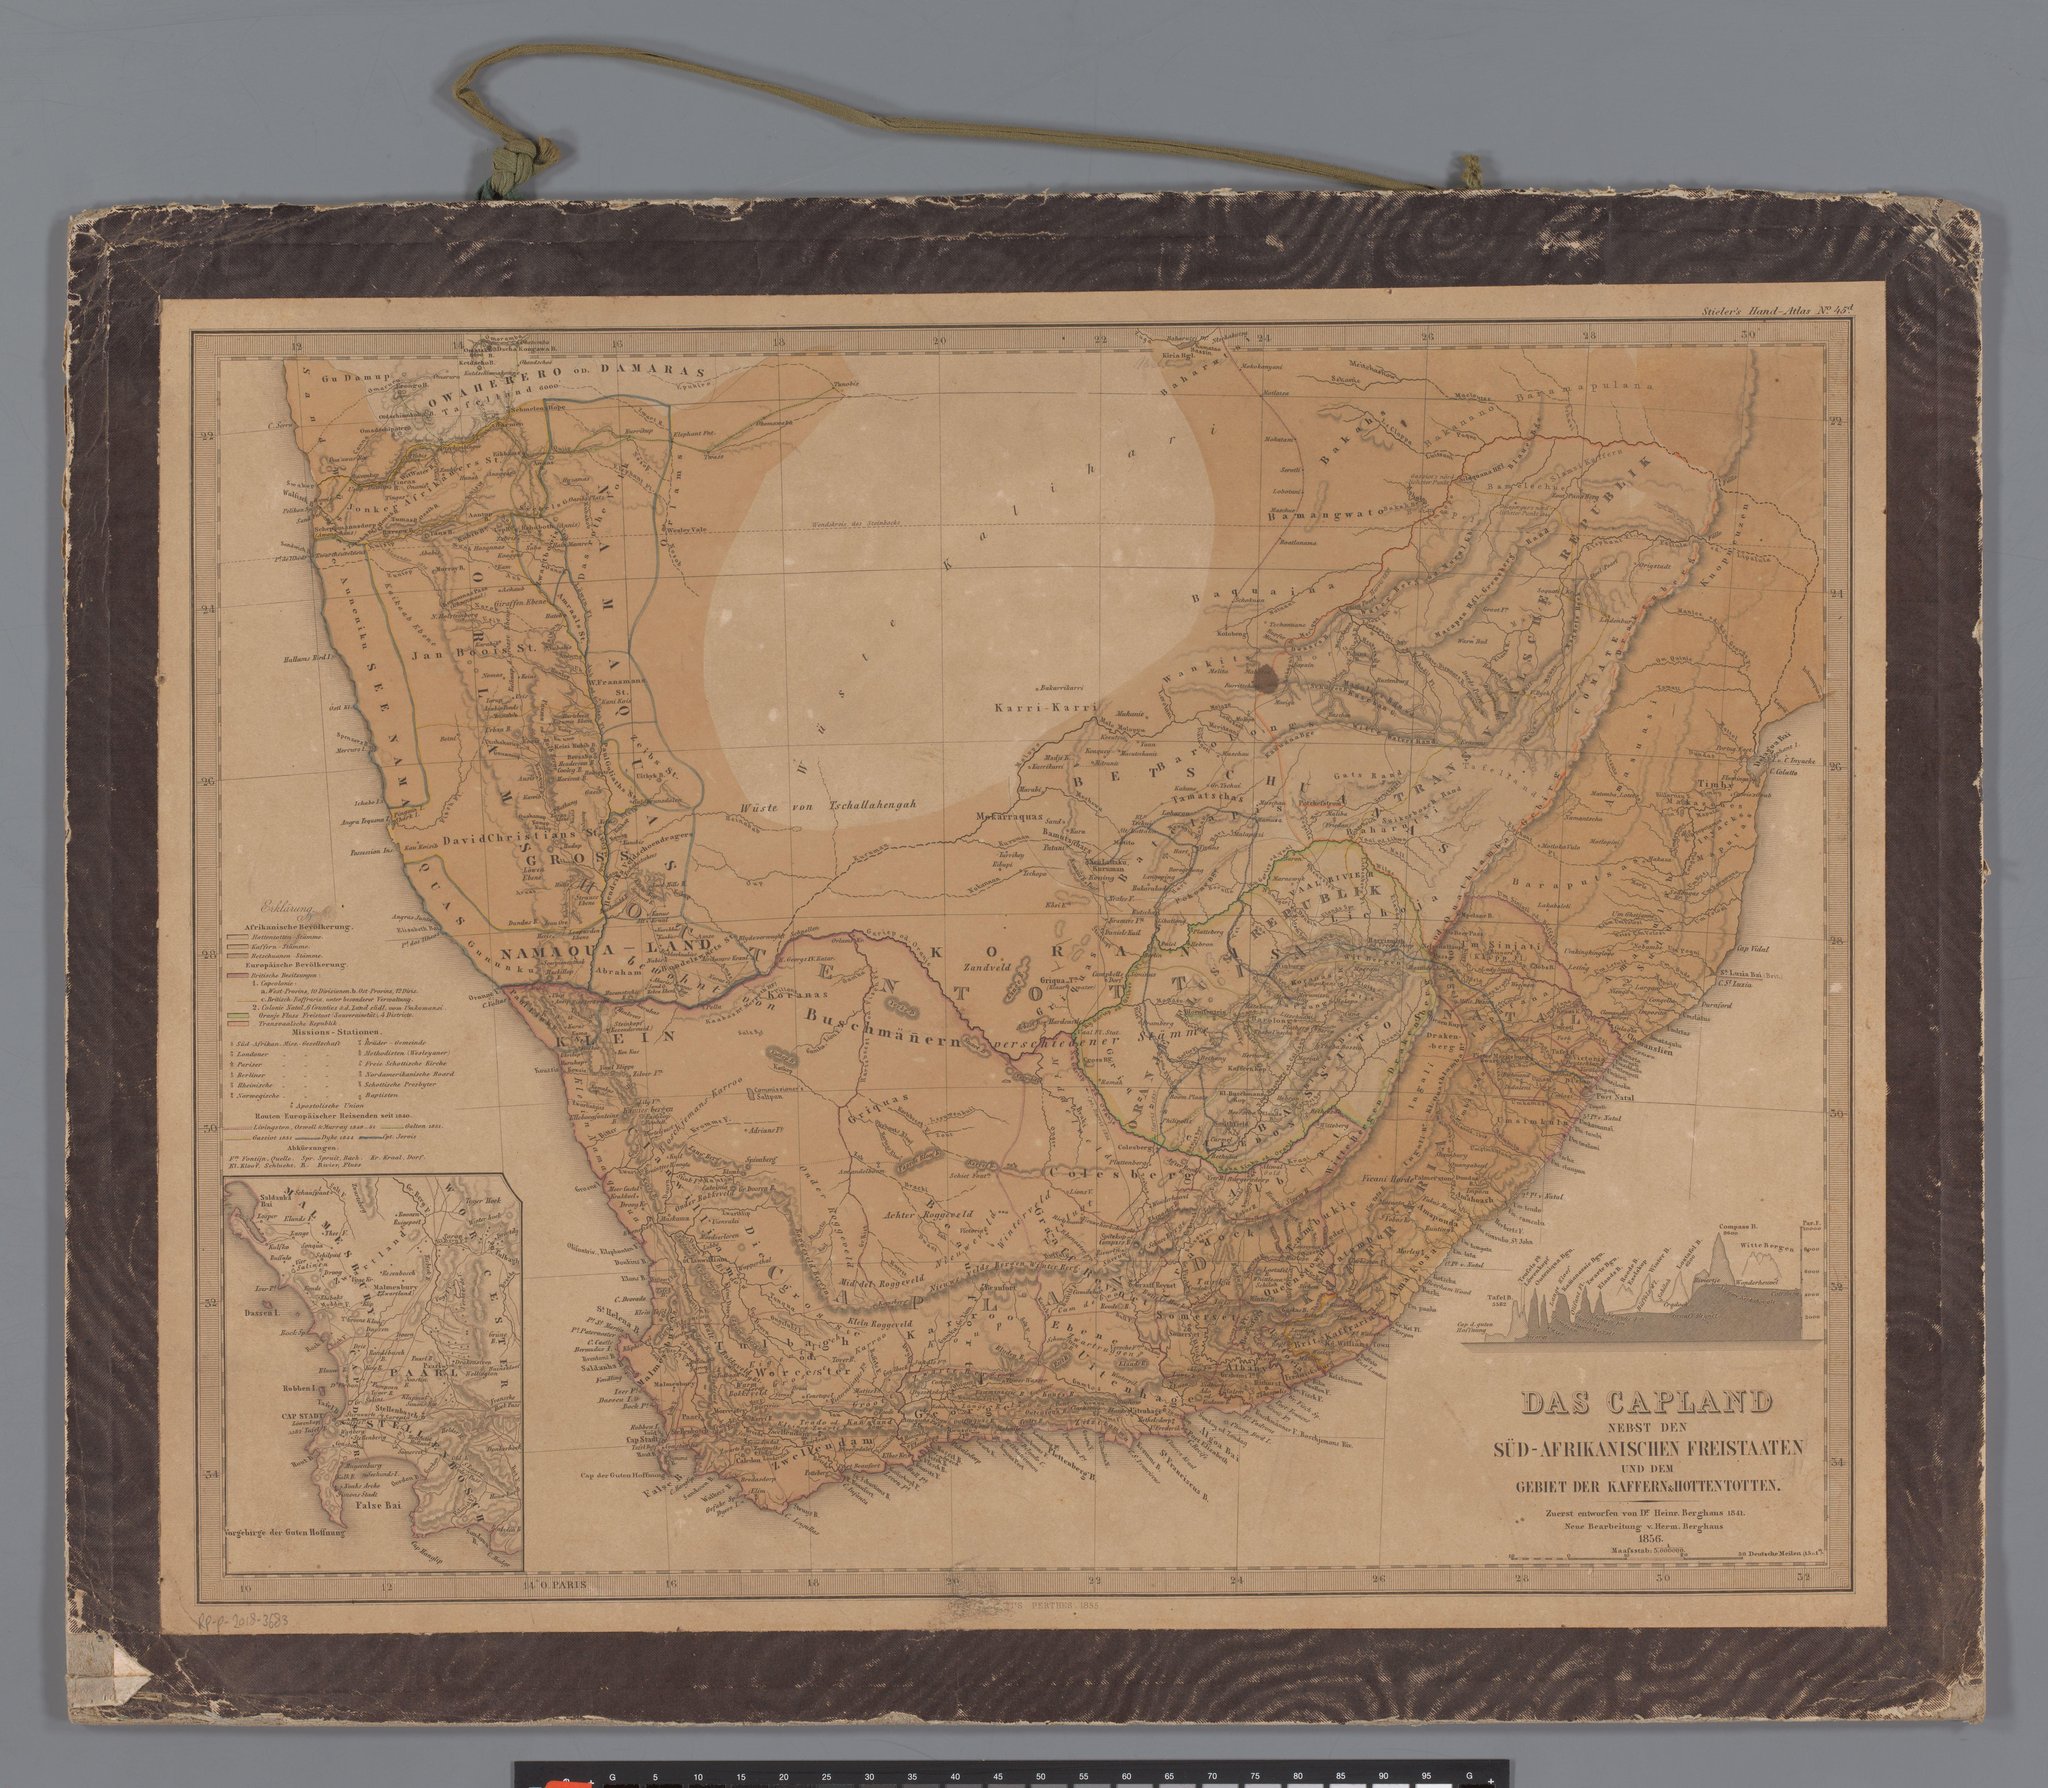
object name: print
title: Das Capland nebst den Süd-Afrikanischen Freistaaten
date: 1841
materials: cardboard, paper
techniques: engraving, etching, hand coloring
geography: gotha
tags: (map of) africa, maps, atlases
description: Prent uit: Stülpnagel, Friedrich von. Stielers Handatlas. Gotha: Uitgeverij Justus Perthes, 1856.